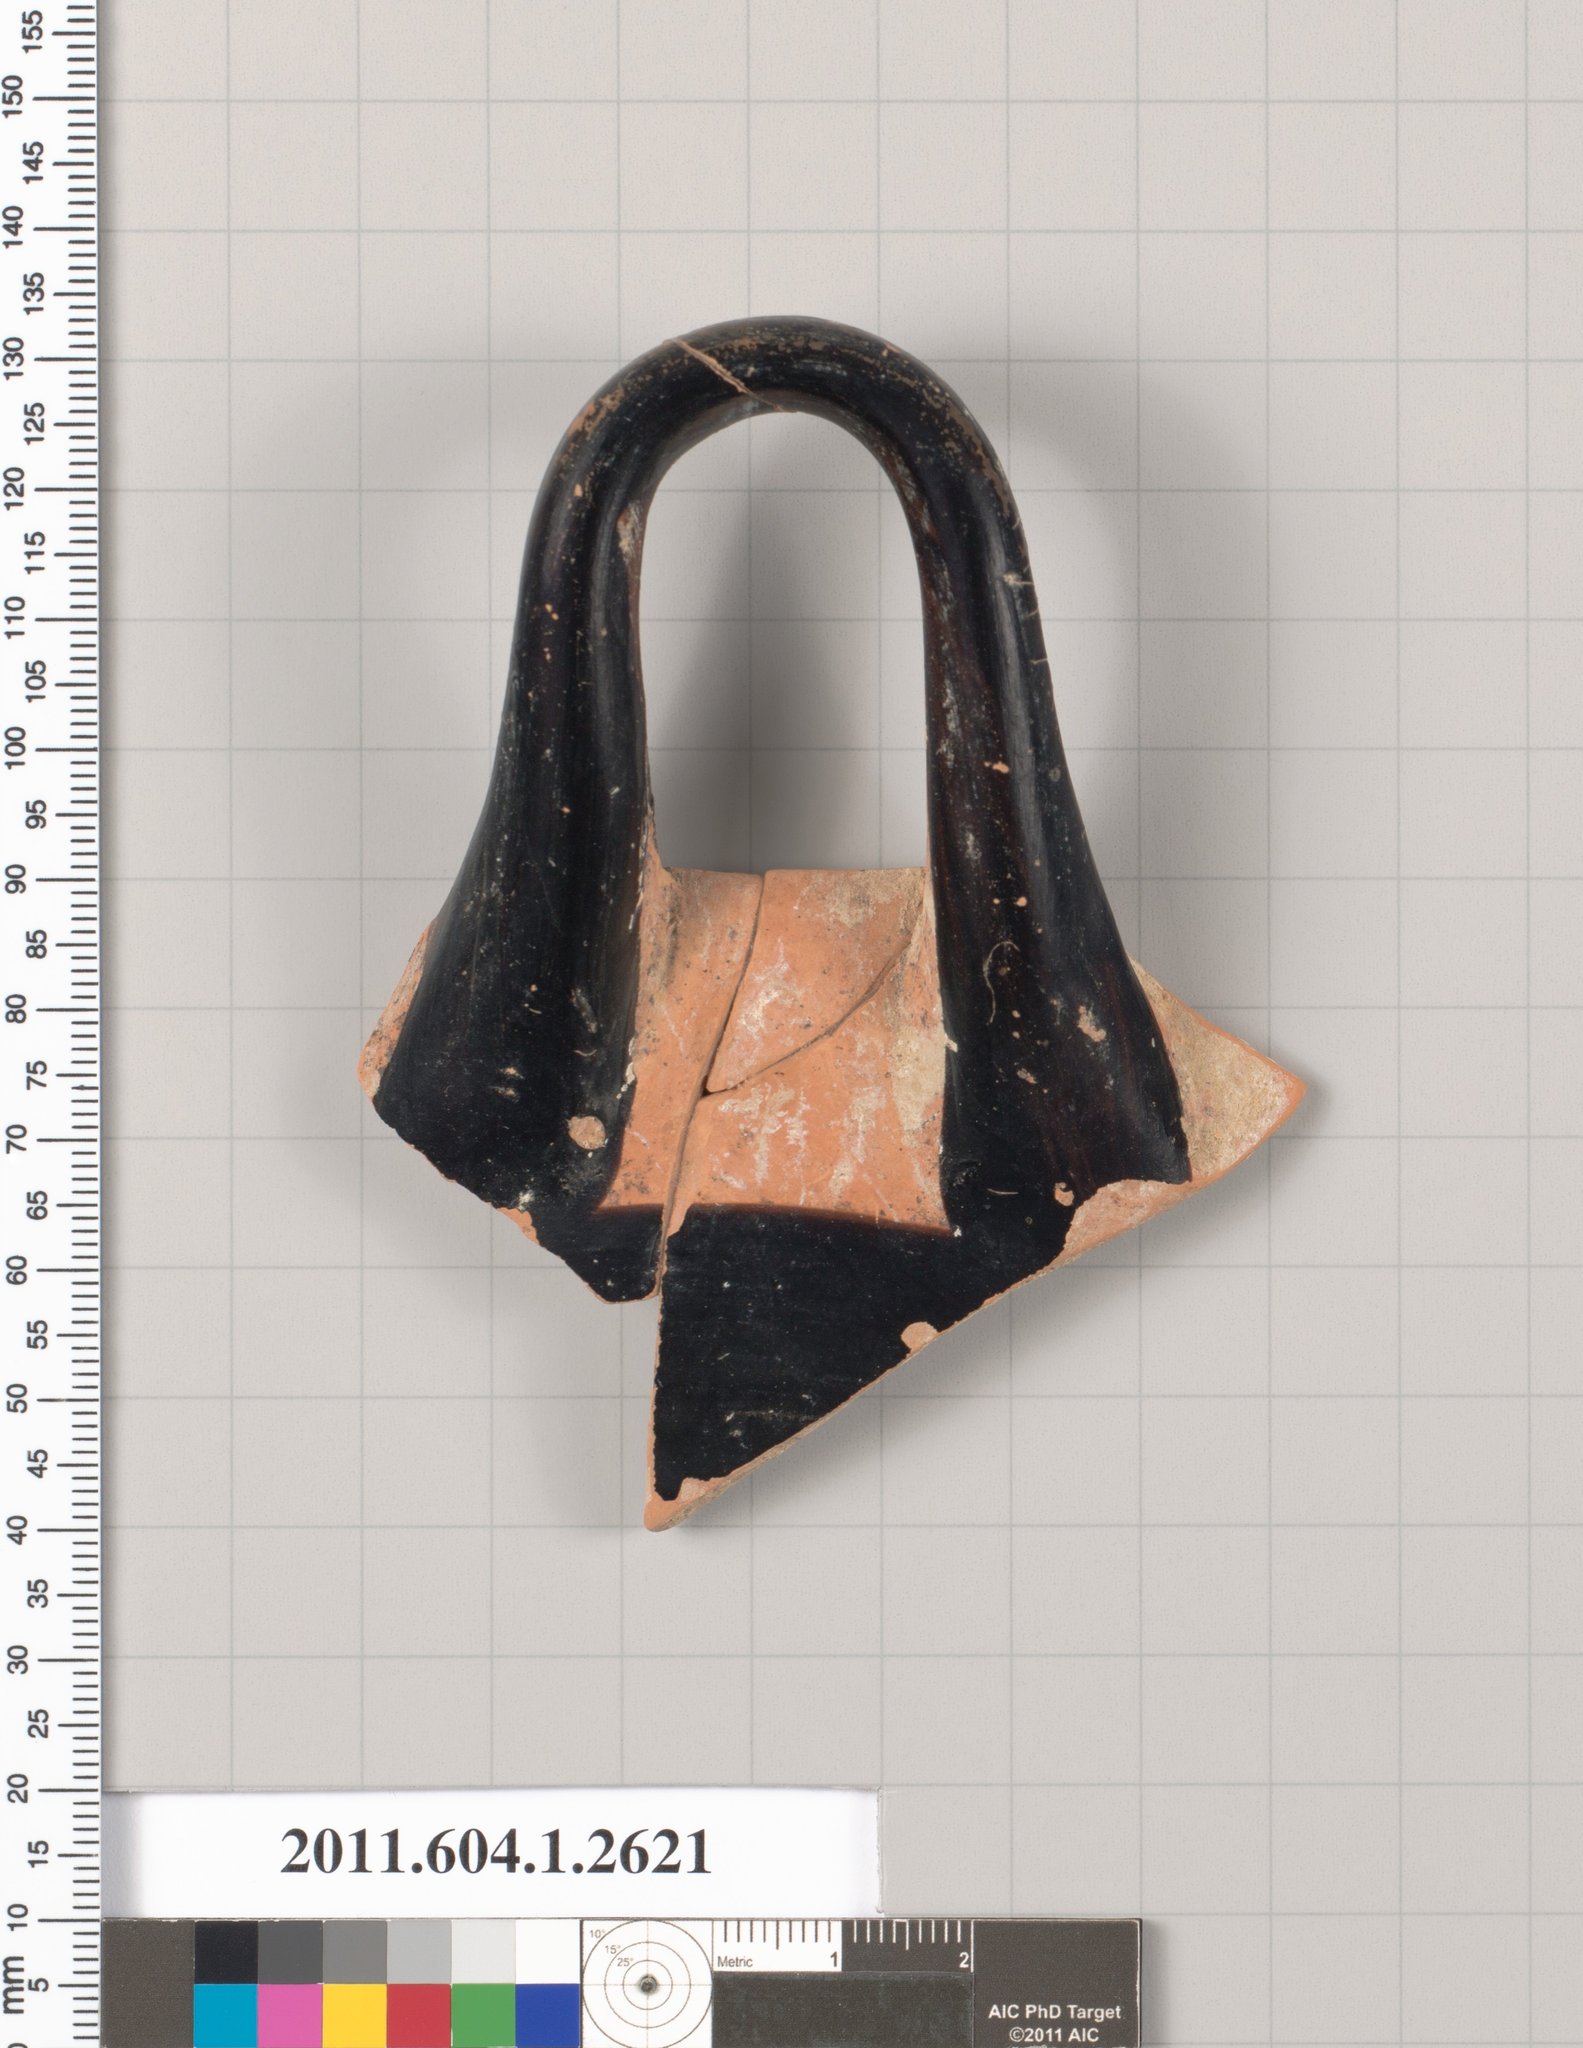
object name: kylix fragment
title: Terracotta fragment of a kylix (drinking cup)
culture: greek, attic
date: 500-401 BCE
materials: terracotta